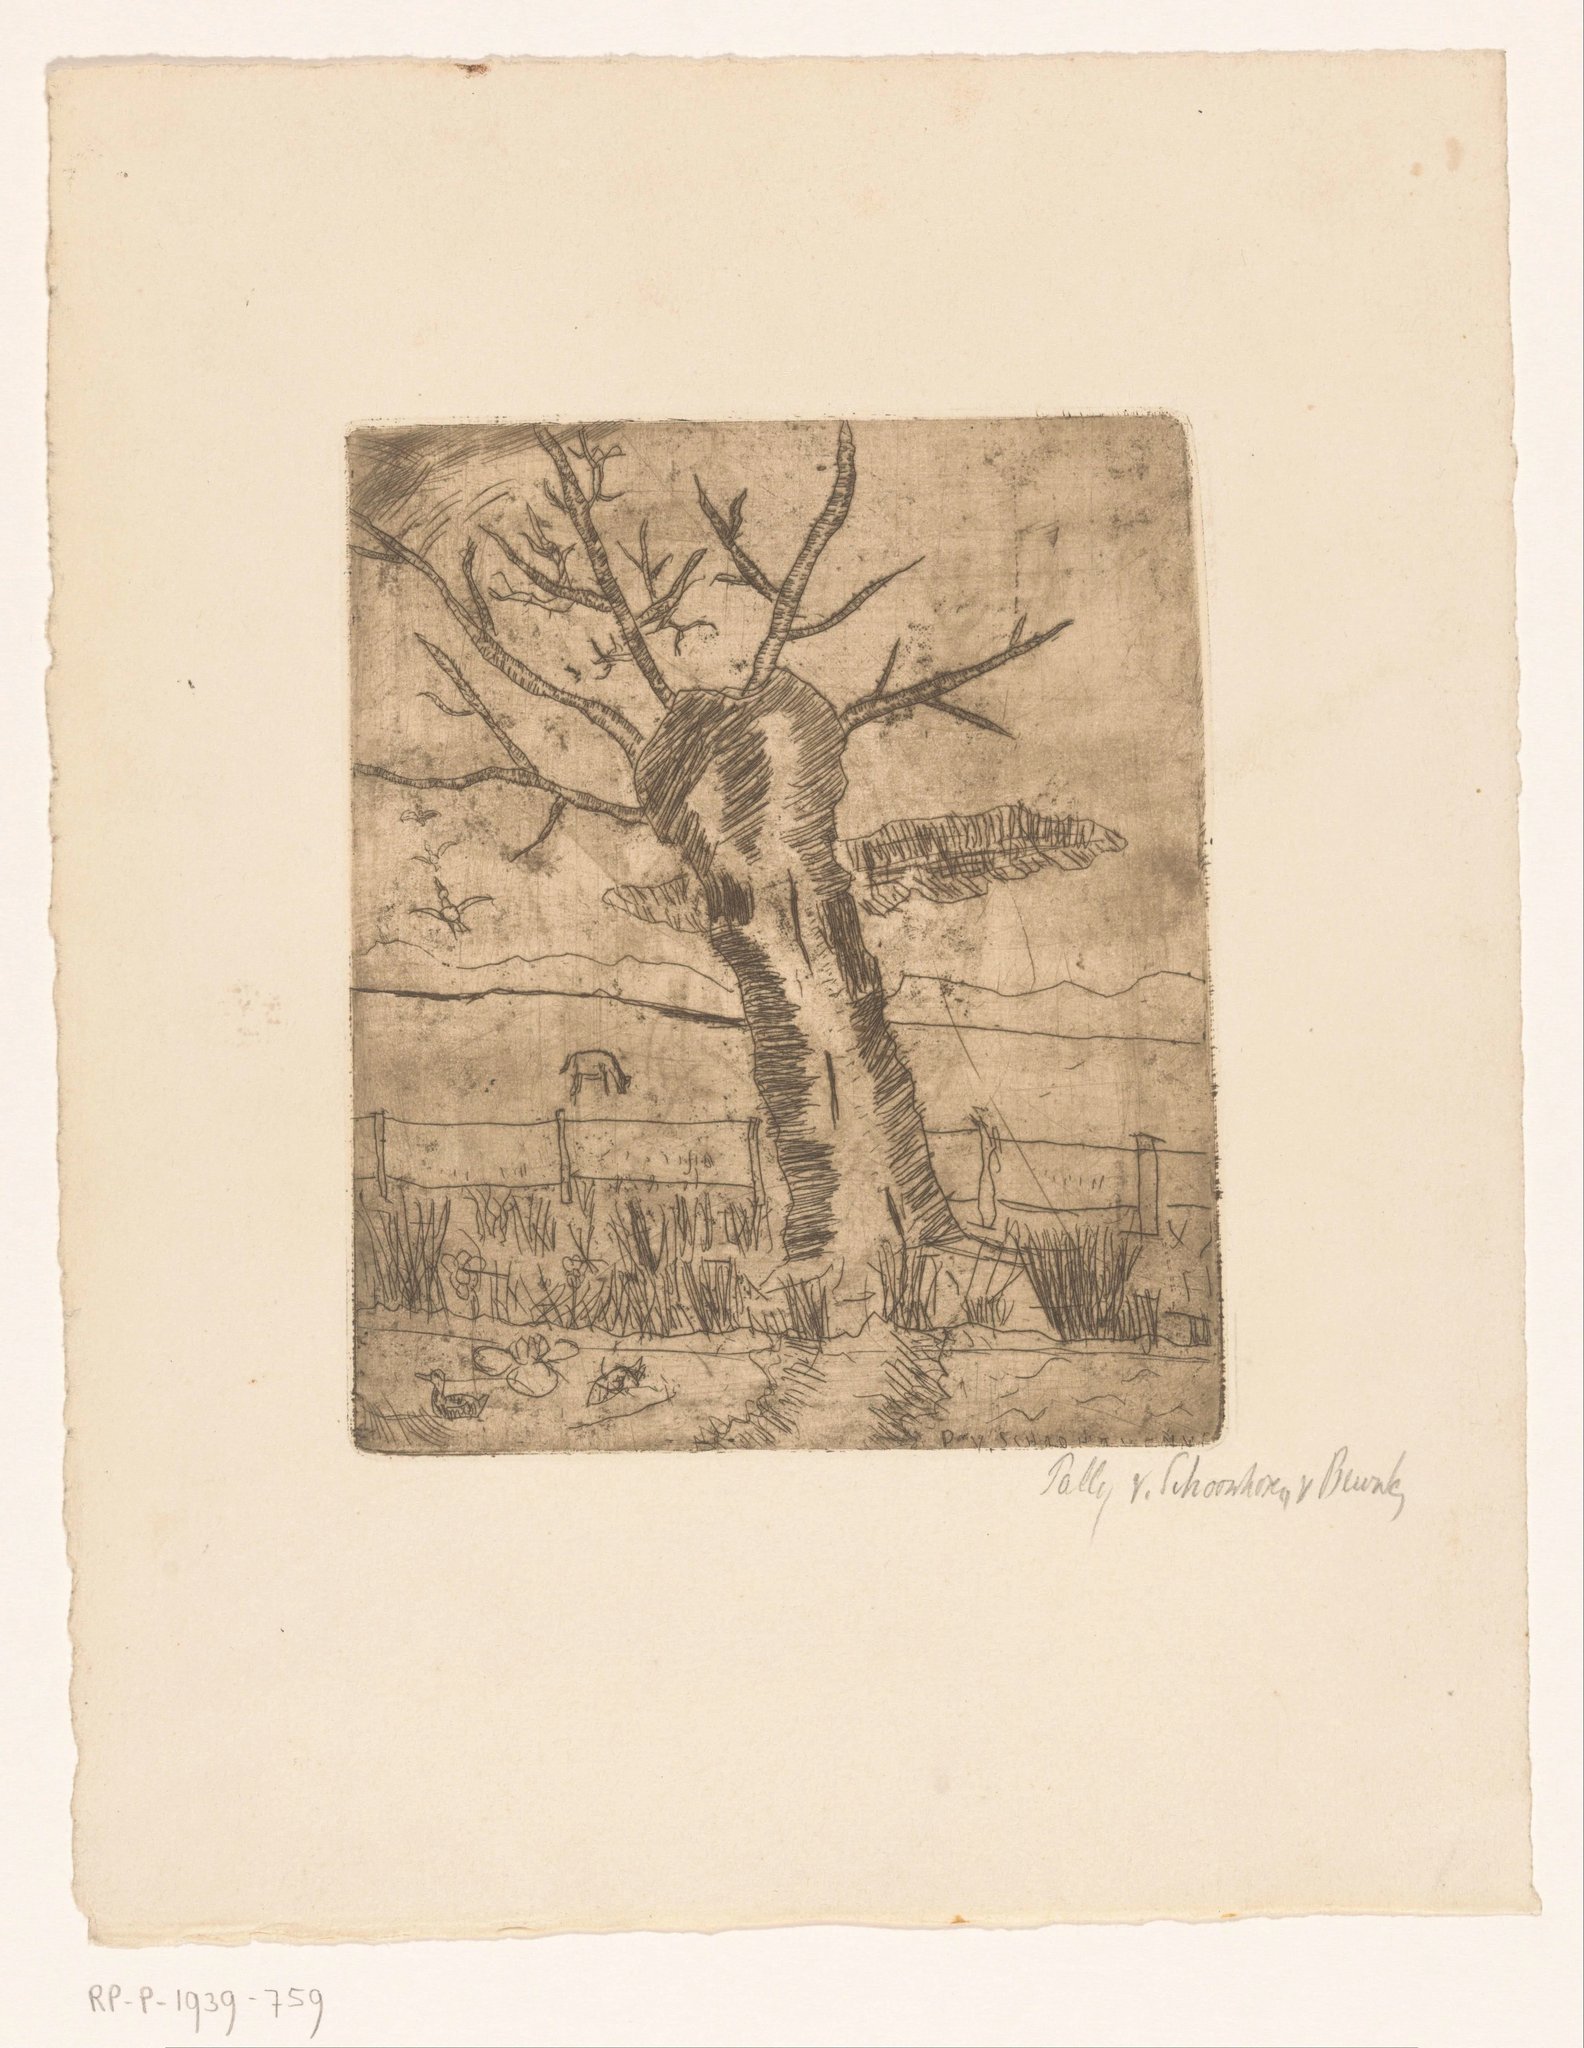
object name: print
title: Knotwilg voor hek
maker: pally van schoonhoven van beurden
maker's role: print maker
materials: paper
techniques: etching, intaglio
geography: netherlands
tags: trees: willow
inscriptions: collector's mark: Lugt 2166, collector's mark: Lugt 2760